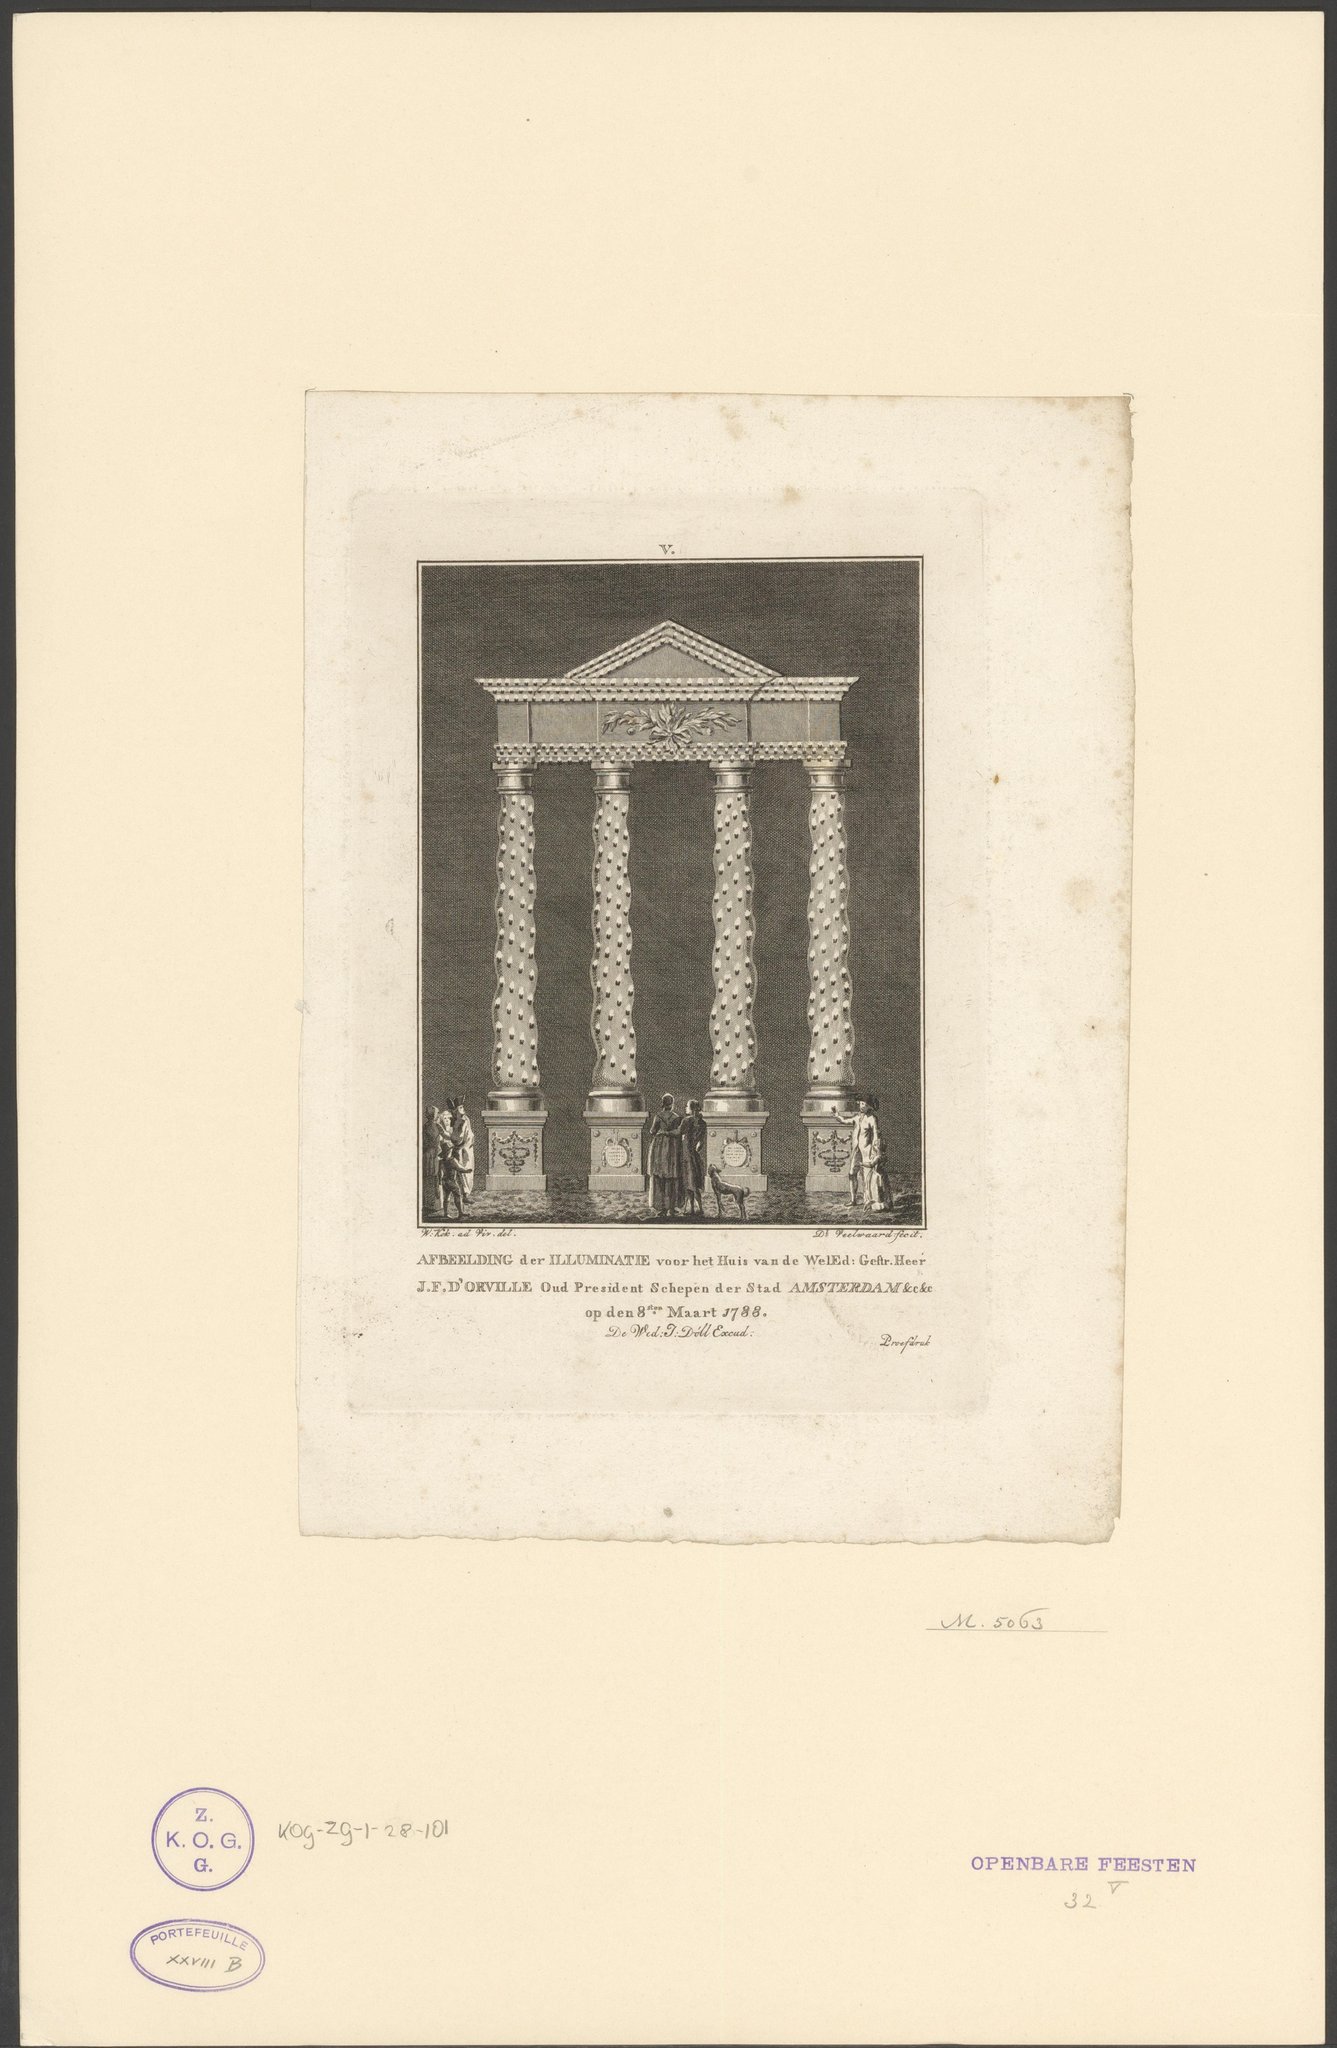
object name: print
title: Illuminatie van het huis van J.F. d'Orville te Amsterdam, 1788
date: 1788-1790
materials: paper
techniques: engraving, etching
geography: amsterdam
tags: the hague, william v (prince of orange), bonfire, fire-works (+ festive decoration ~ festive activities), amsterdam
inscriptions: stamp, collector's mark: Lugt 1641, stamp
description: Illuminatie aangebracht voor het huis van J.F. d'Orville te Amsterdam. Genummerd bovenaan: V. Onderdeel van een reeks van twaalf platen van de illuminaties en decoraties te Amsterdam op de 40ste verjaardag van prins Willem V op 8 maart 1788. Onderwerpsrubrieken binnen de Atlas Zeden en Gewoonten: Zeden en Gewoonten in Engeren Zin. Volksleven. Openbare feesten. Vorstelijke intochten, (Illuminaties, vuurwerken en dergelijke, openbare feesten).